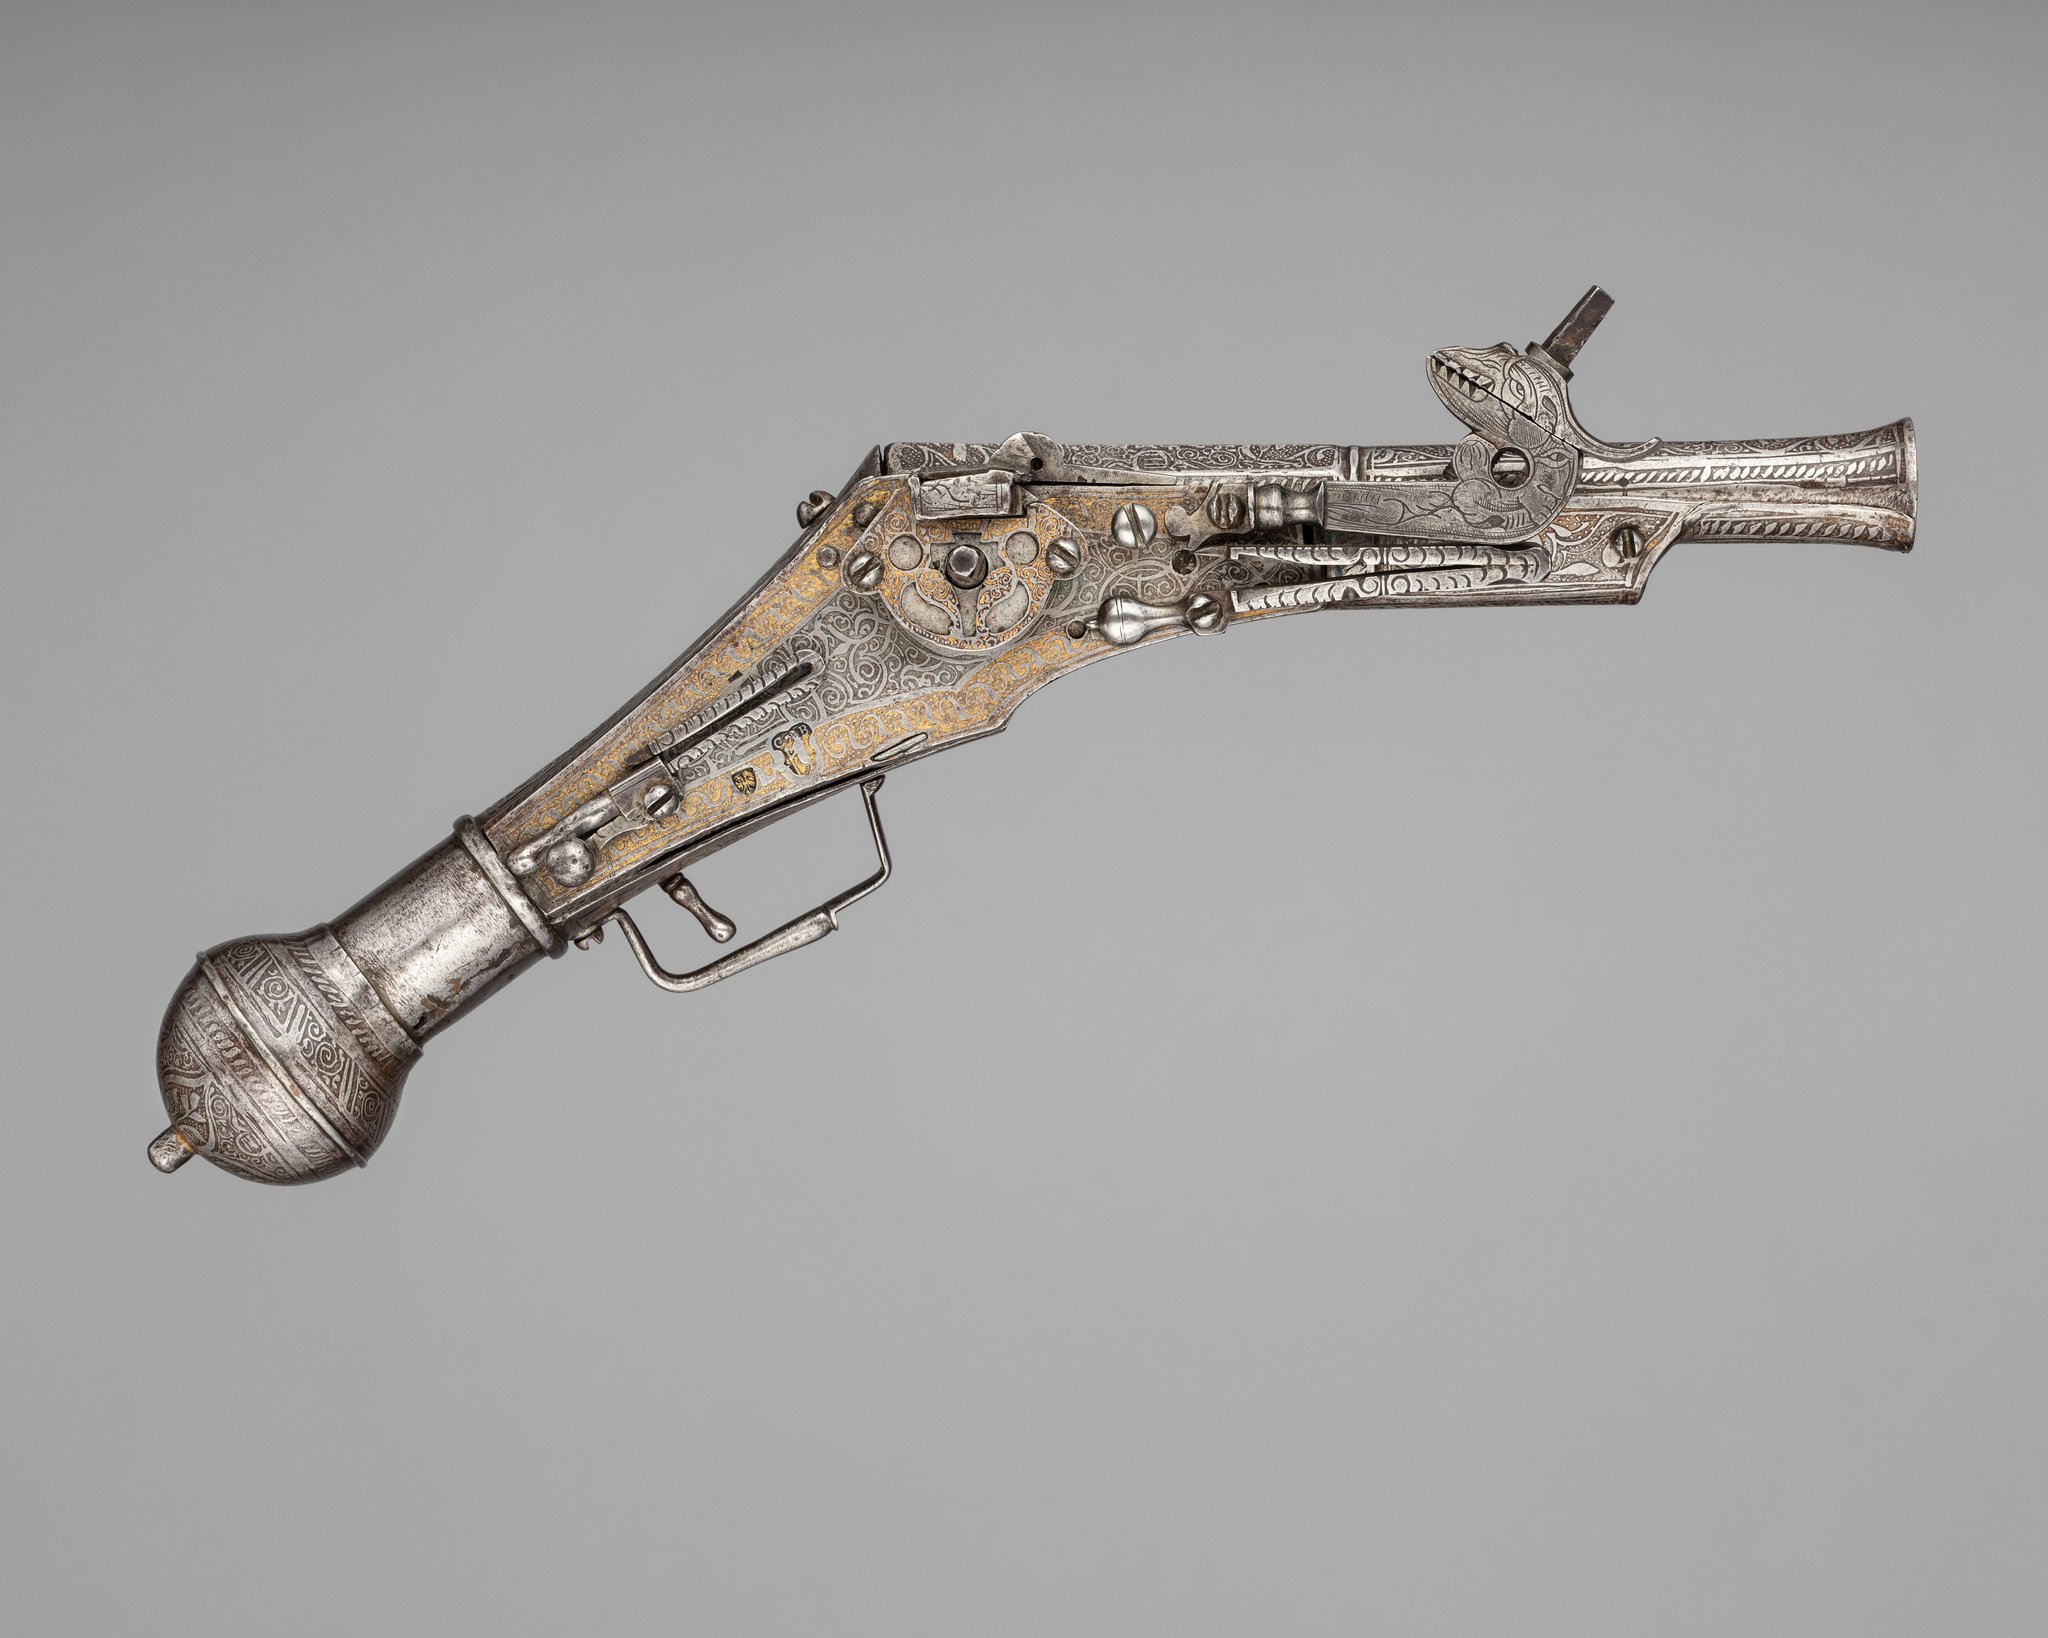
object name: wheellock pistol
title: Two Wheellock Pistols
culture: german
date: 1600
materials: gold, iron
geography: germany